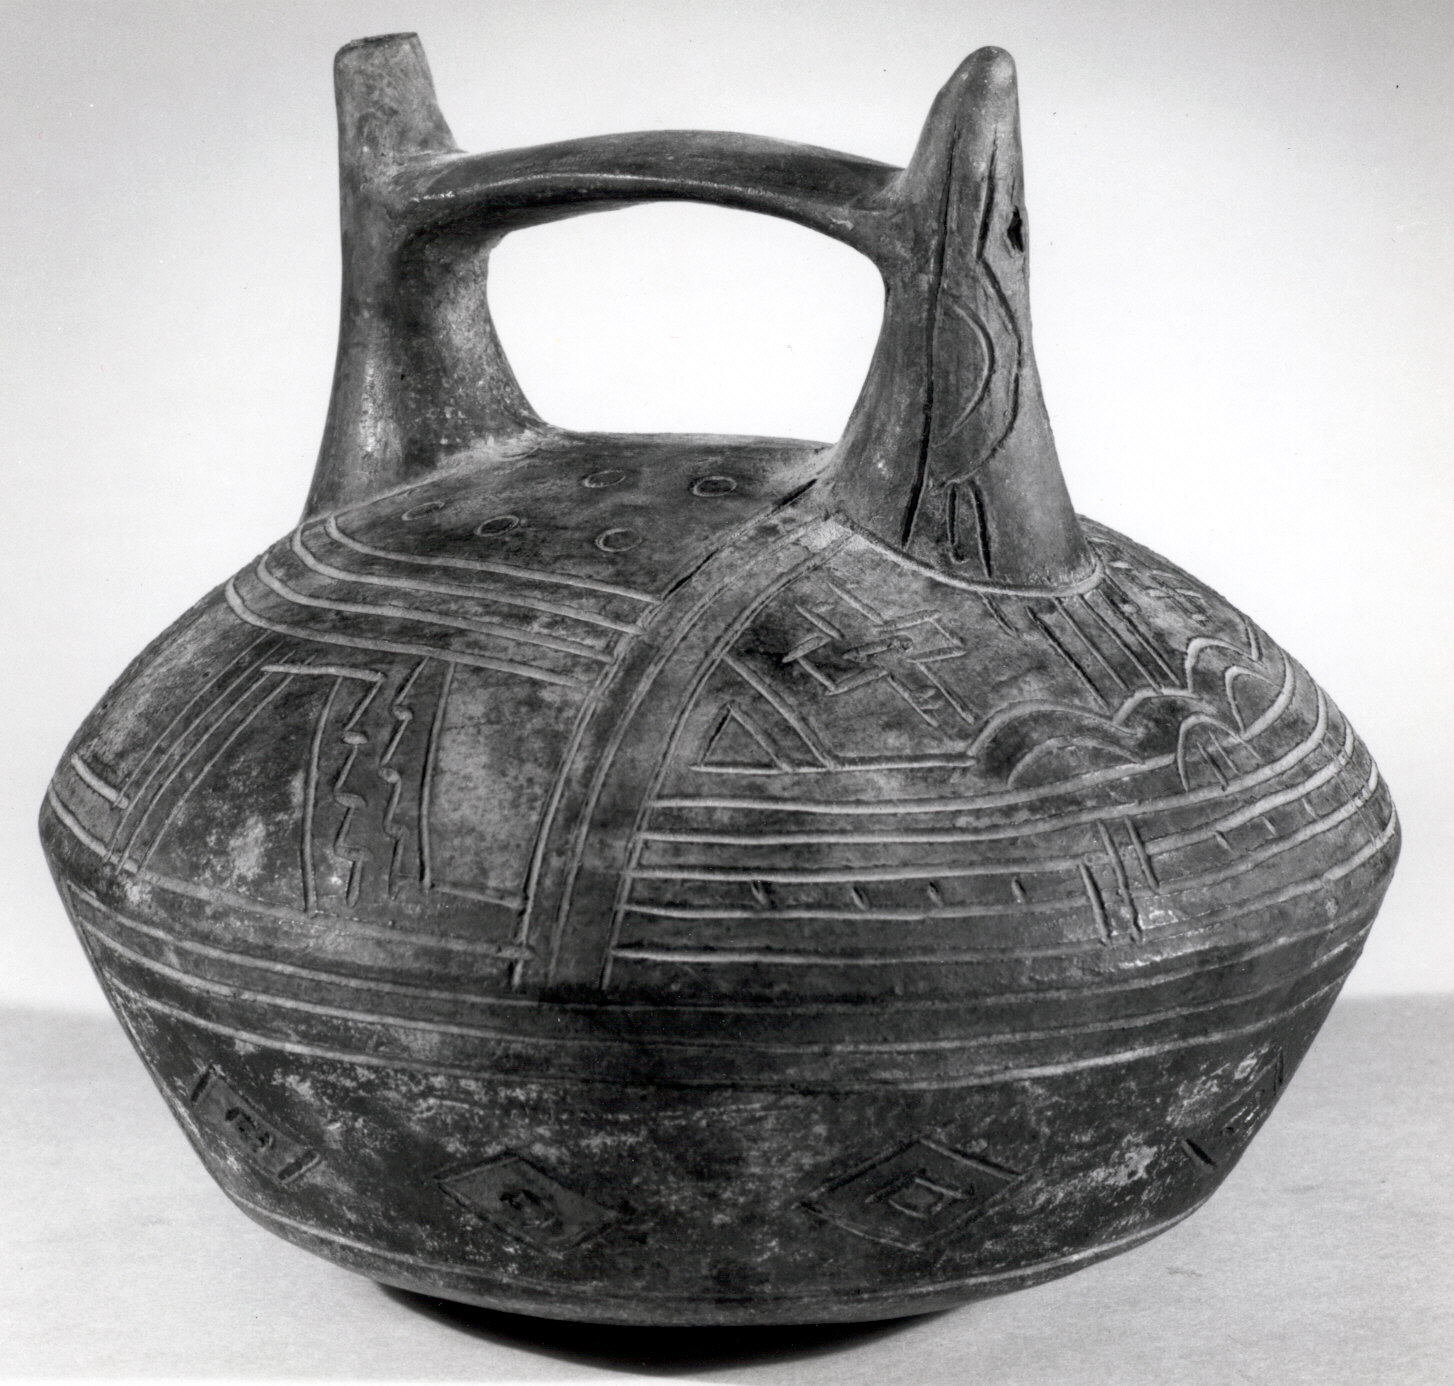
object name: bottle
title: Double Spout and Bridge Bottle with Bird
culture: paracas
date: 500-101 BCE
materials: ceramic, pigment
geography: peru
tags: birds